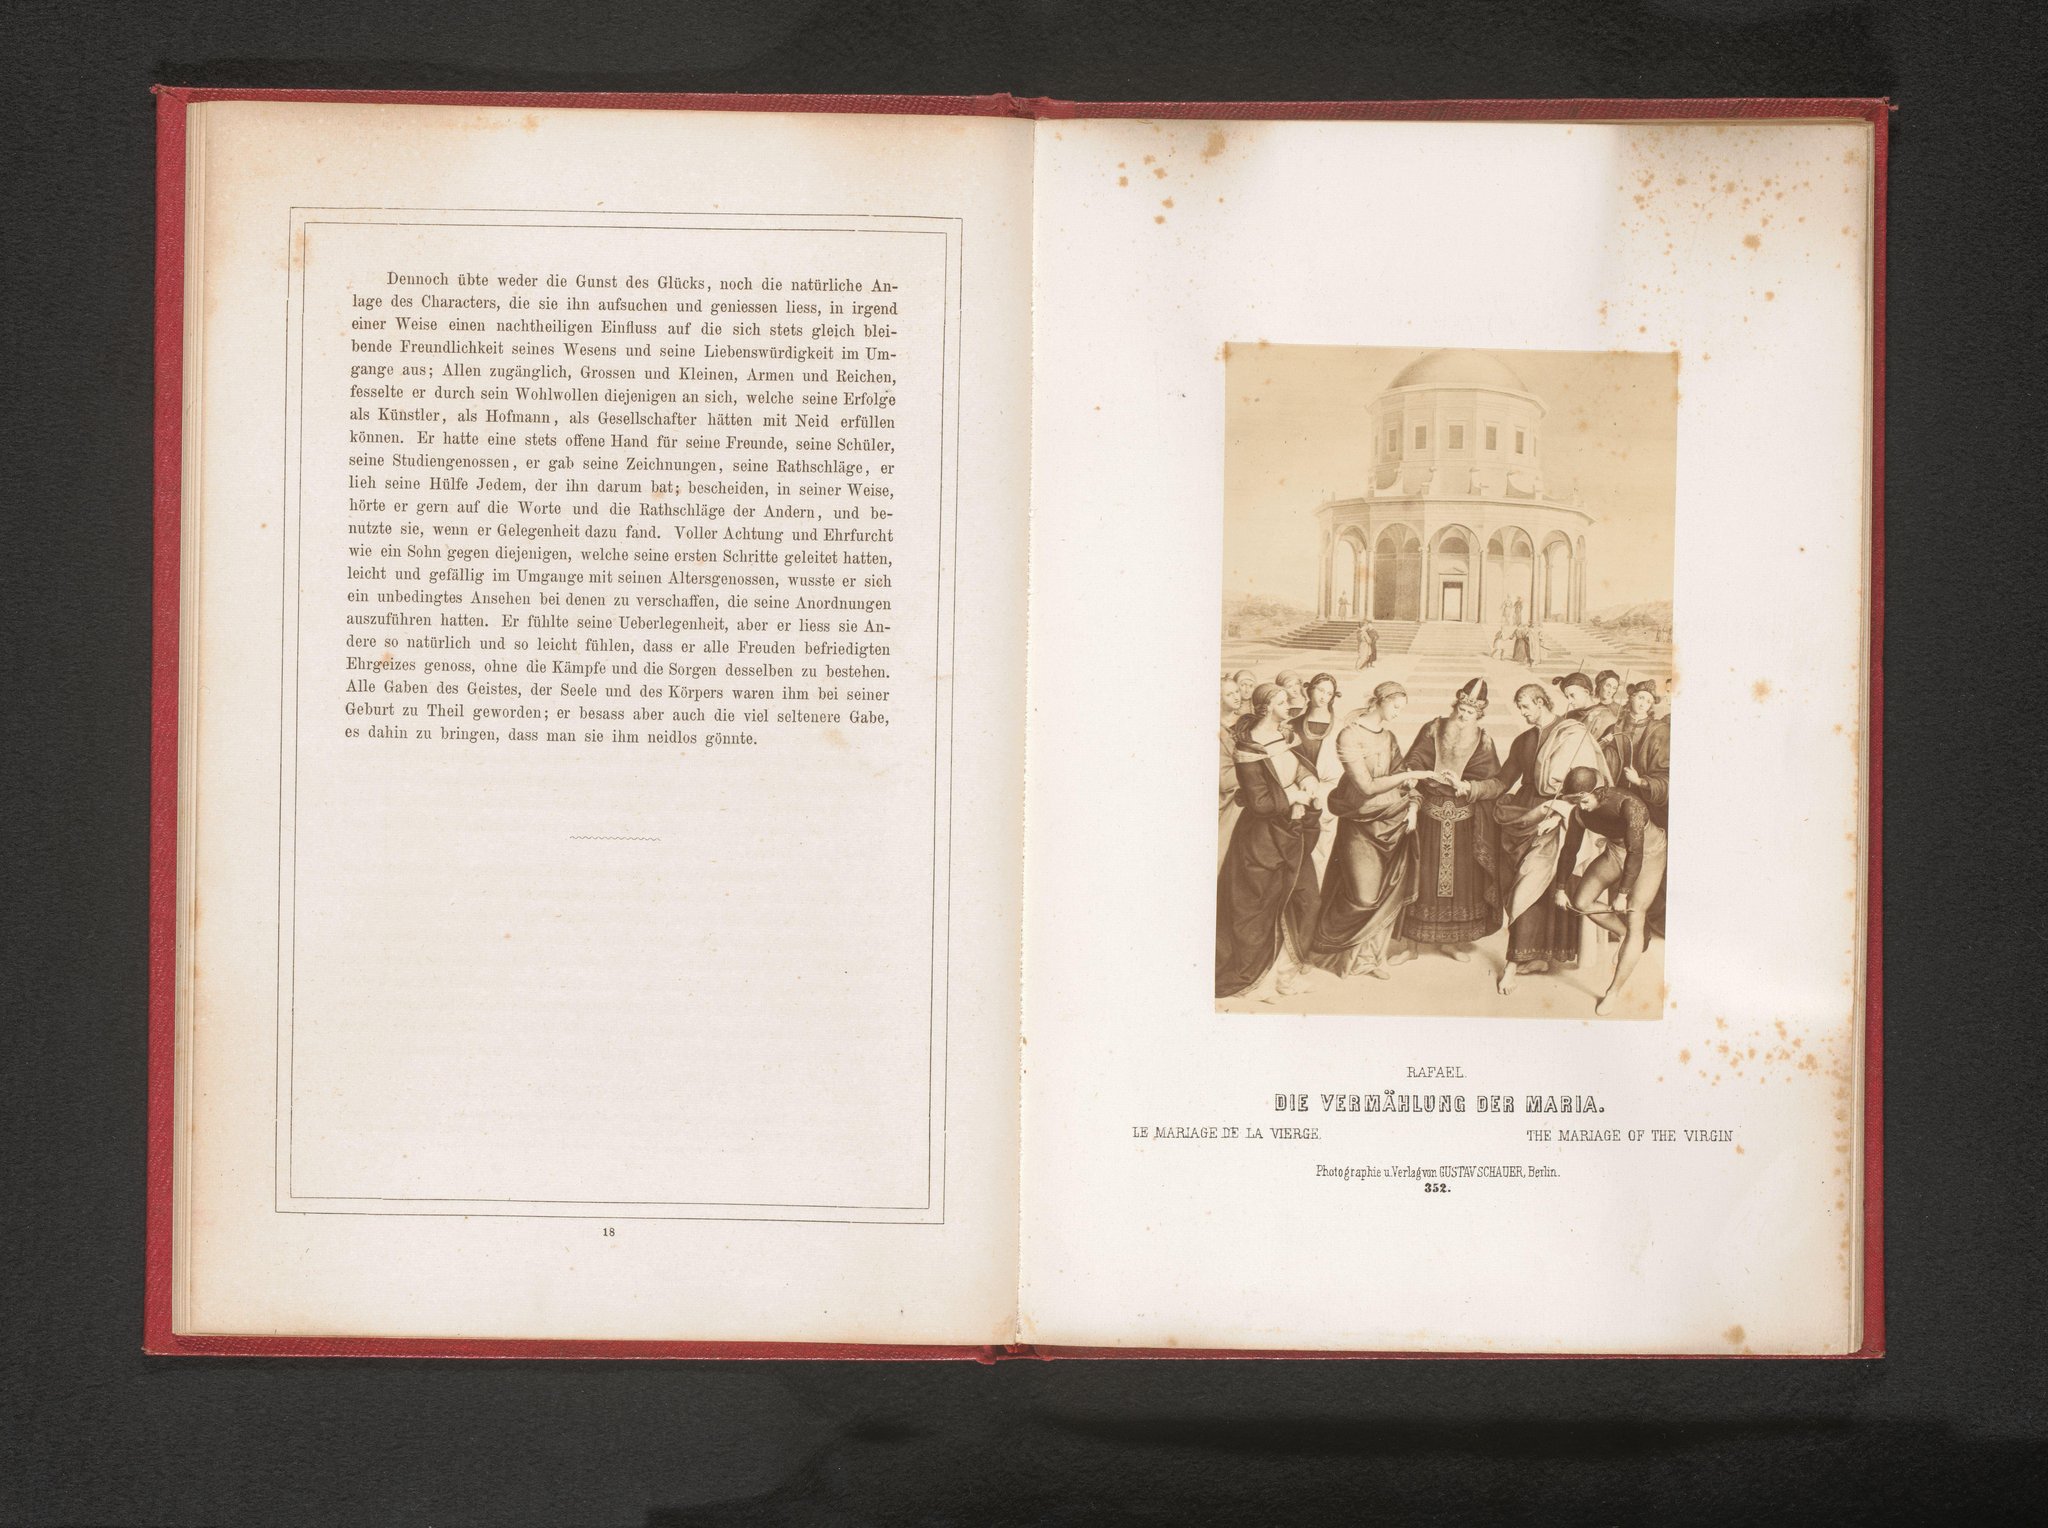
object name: photograph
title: Die Vermählung der Maria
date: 1856-1861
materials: photographic support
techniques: albumen print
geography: berlin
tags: marriage of mary and joseph, 'sposalizio': they are married by the high priest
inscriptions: number: ‘352.’